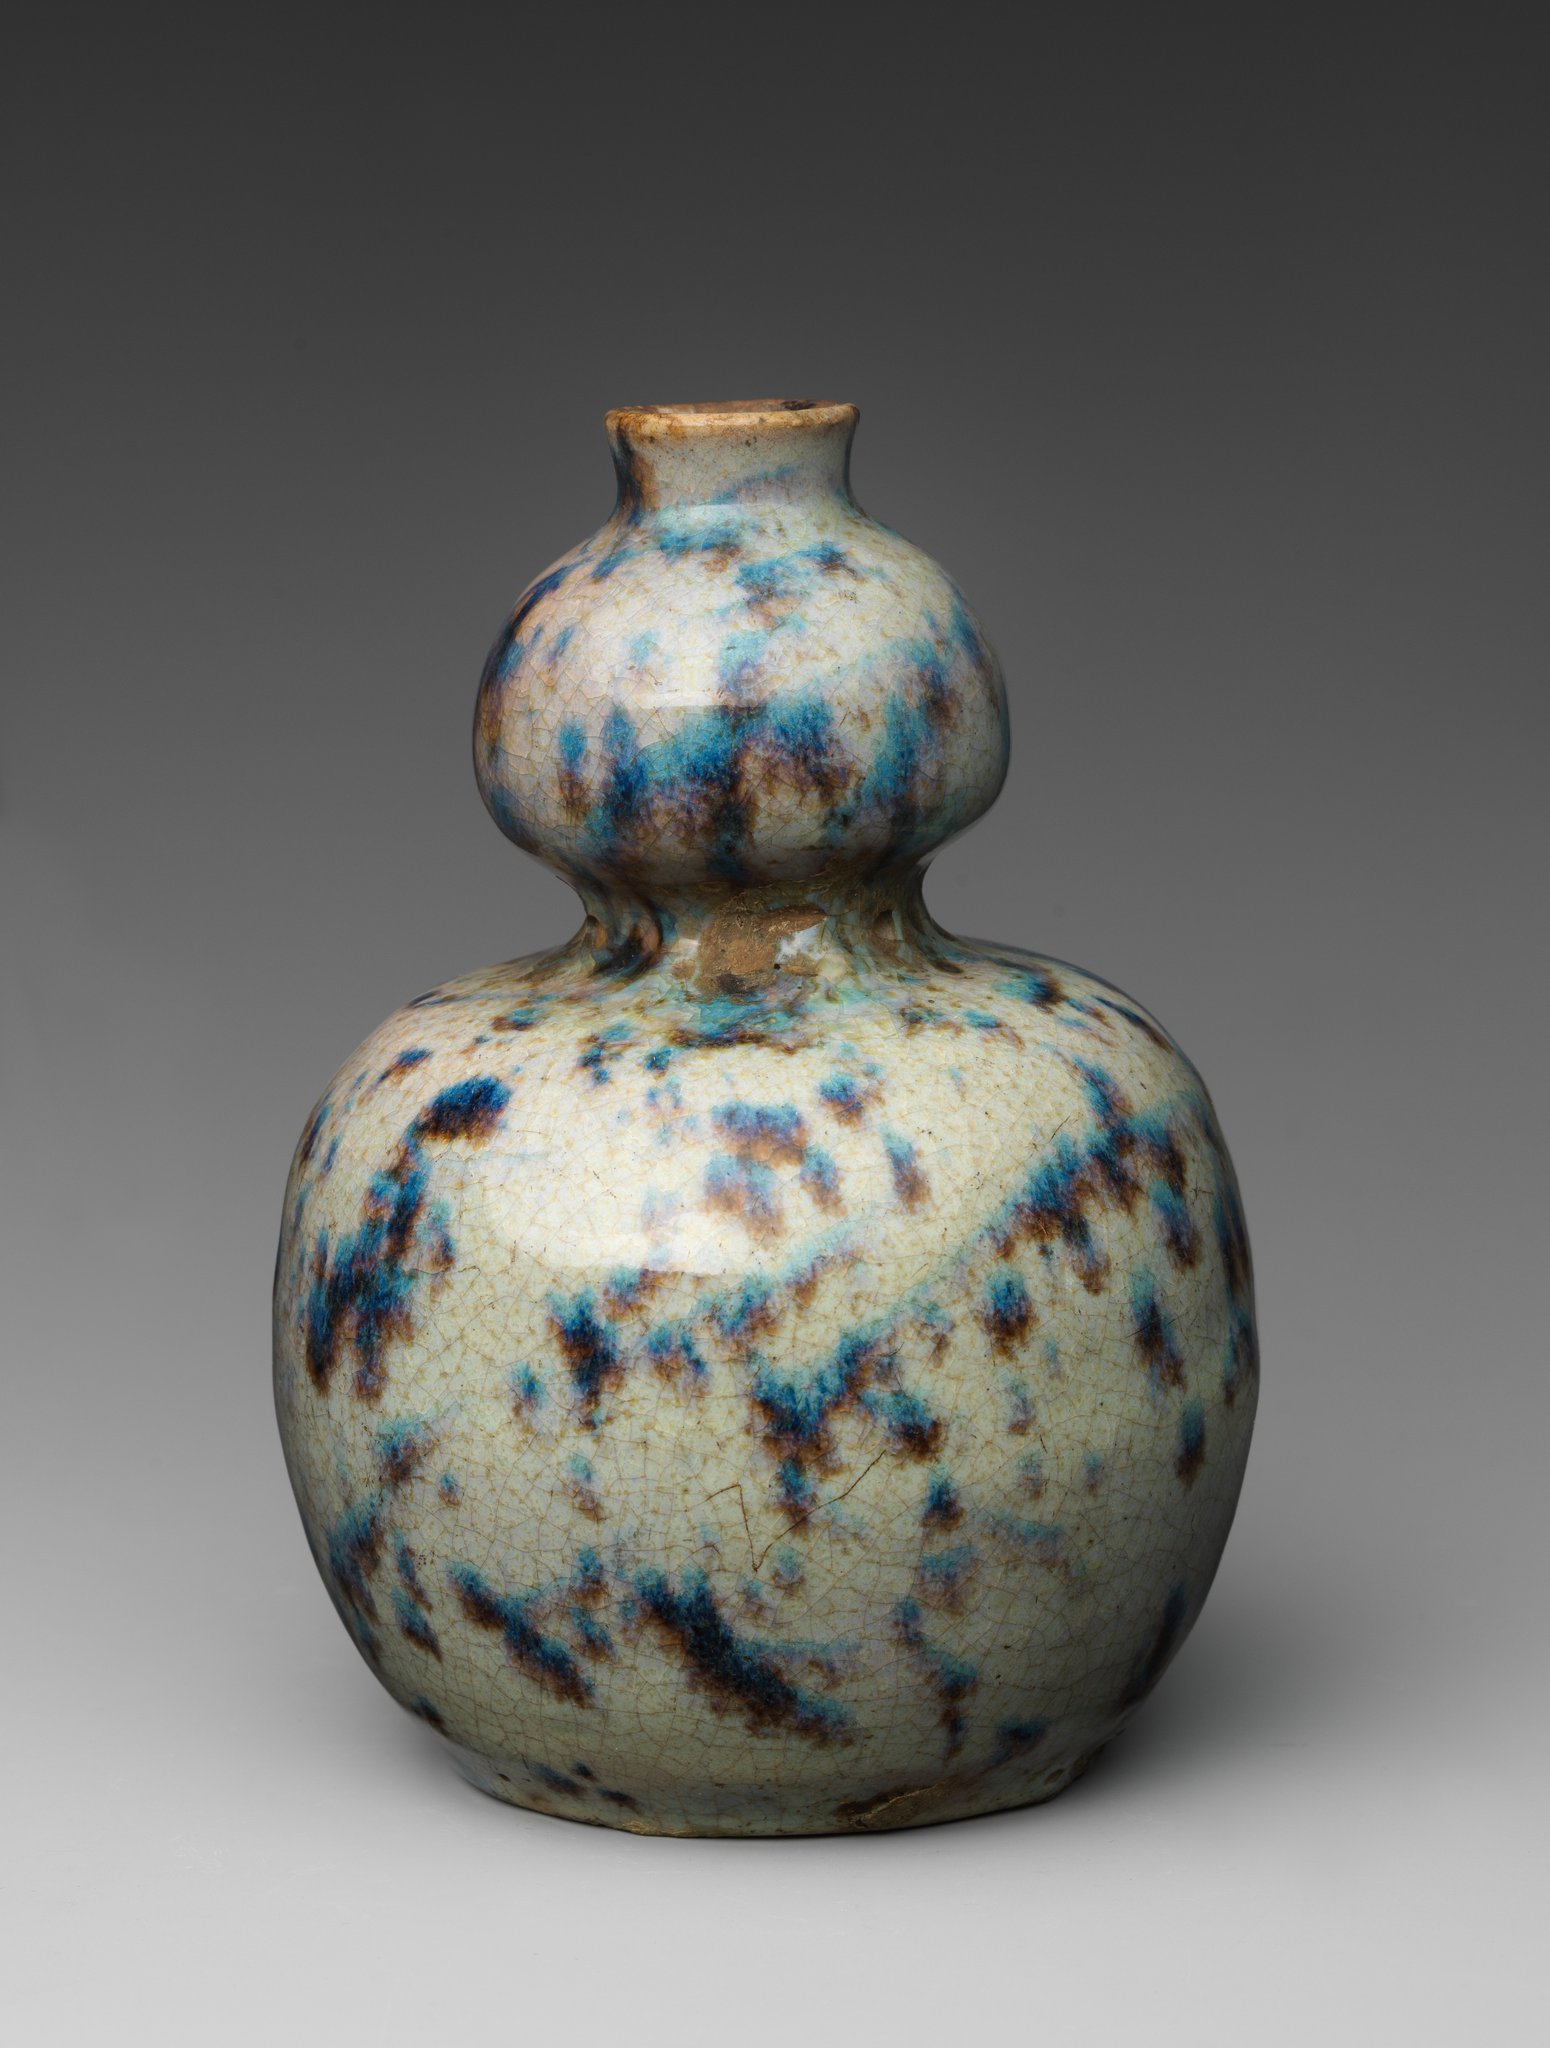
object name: bottle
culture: japanese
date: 1701-1900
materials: glaze, pottery